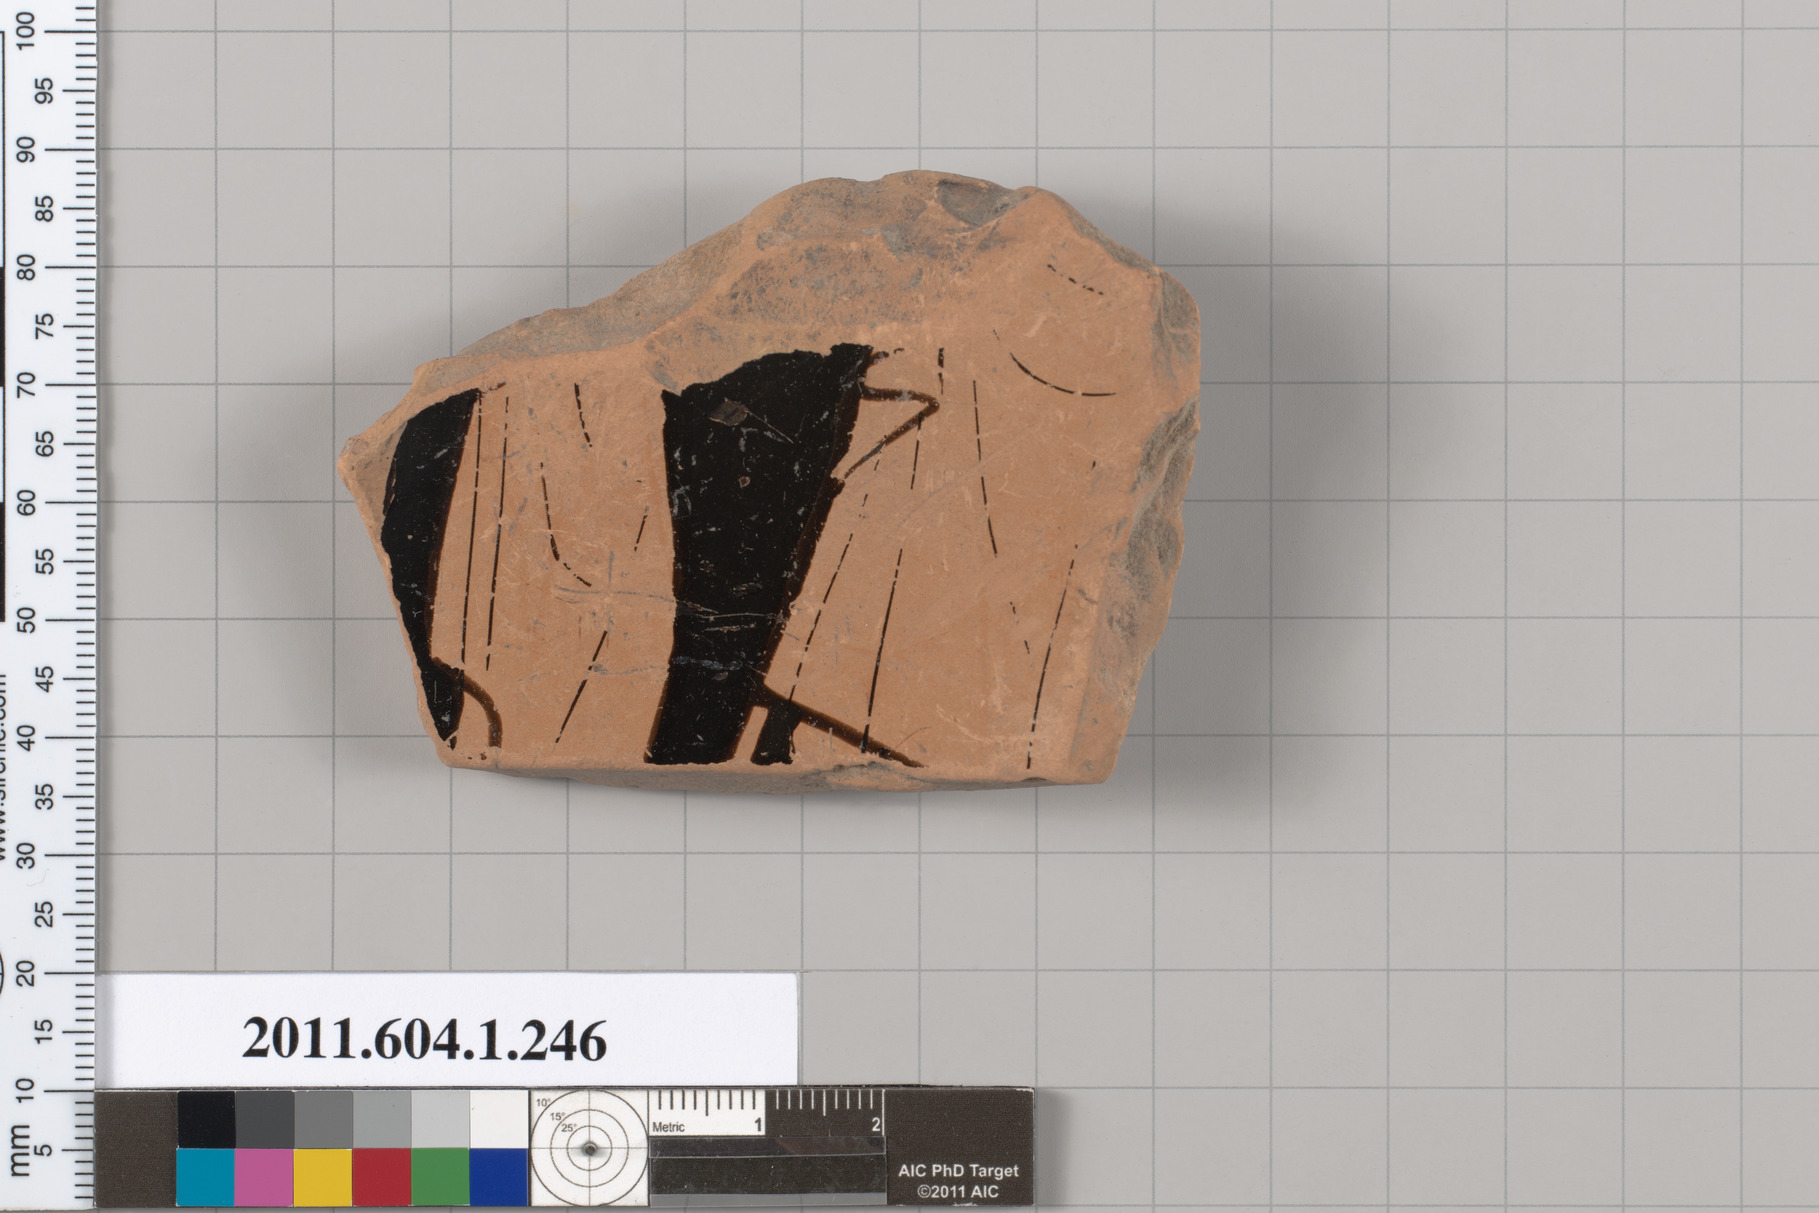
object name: kylix fragment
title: Terracotta fragment of a kylix (drinking cup)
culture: greek, attic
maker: angular painter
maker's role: artist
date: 475-451 BCE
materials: terracotta